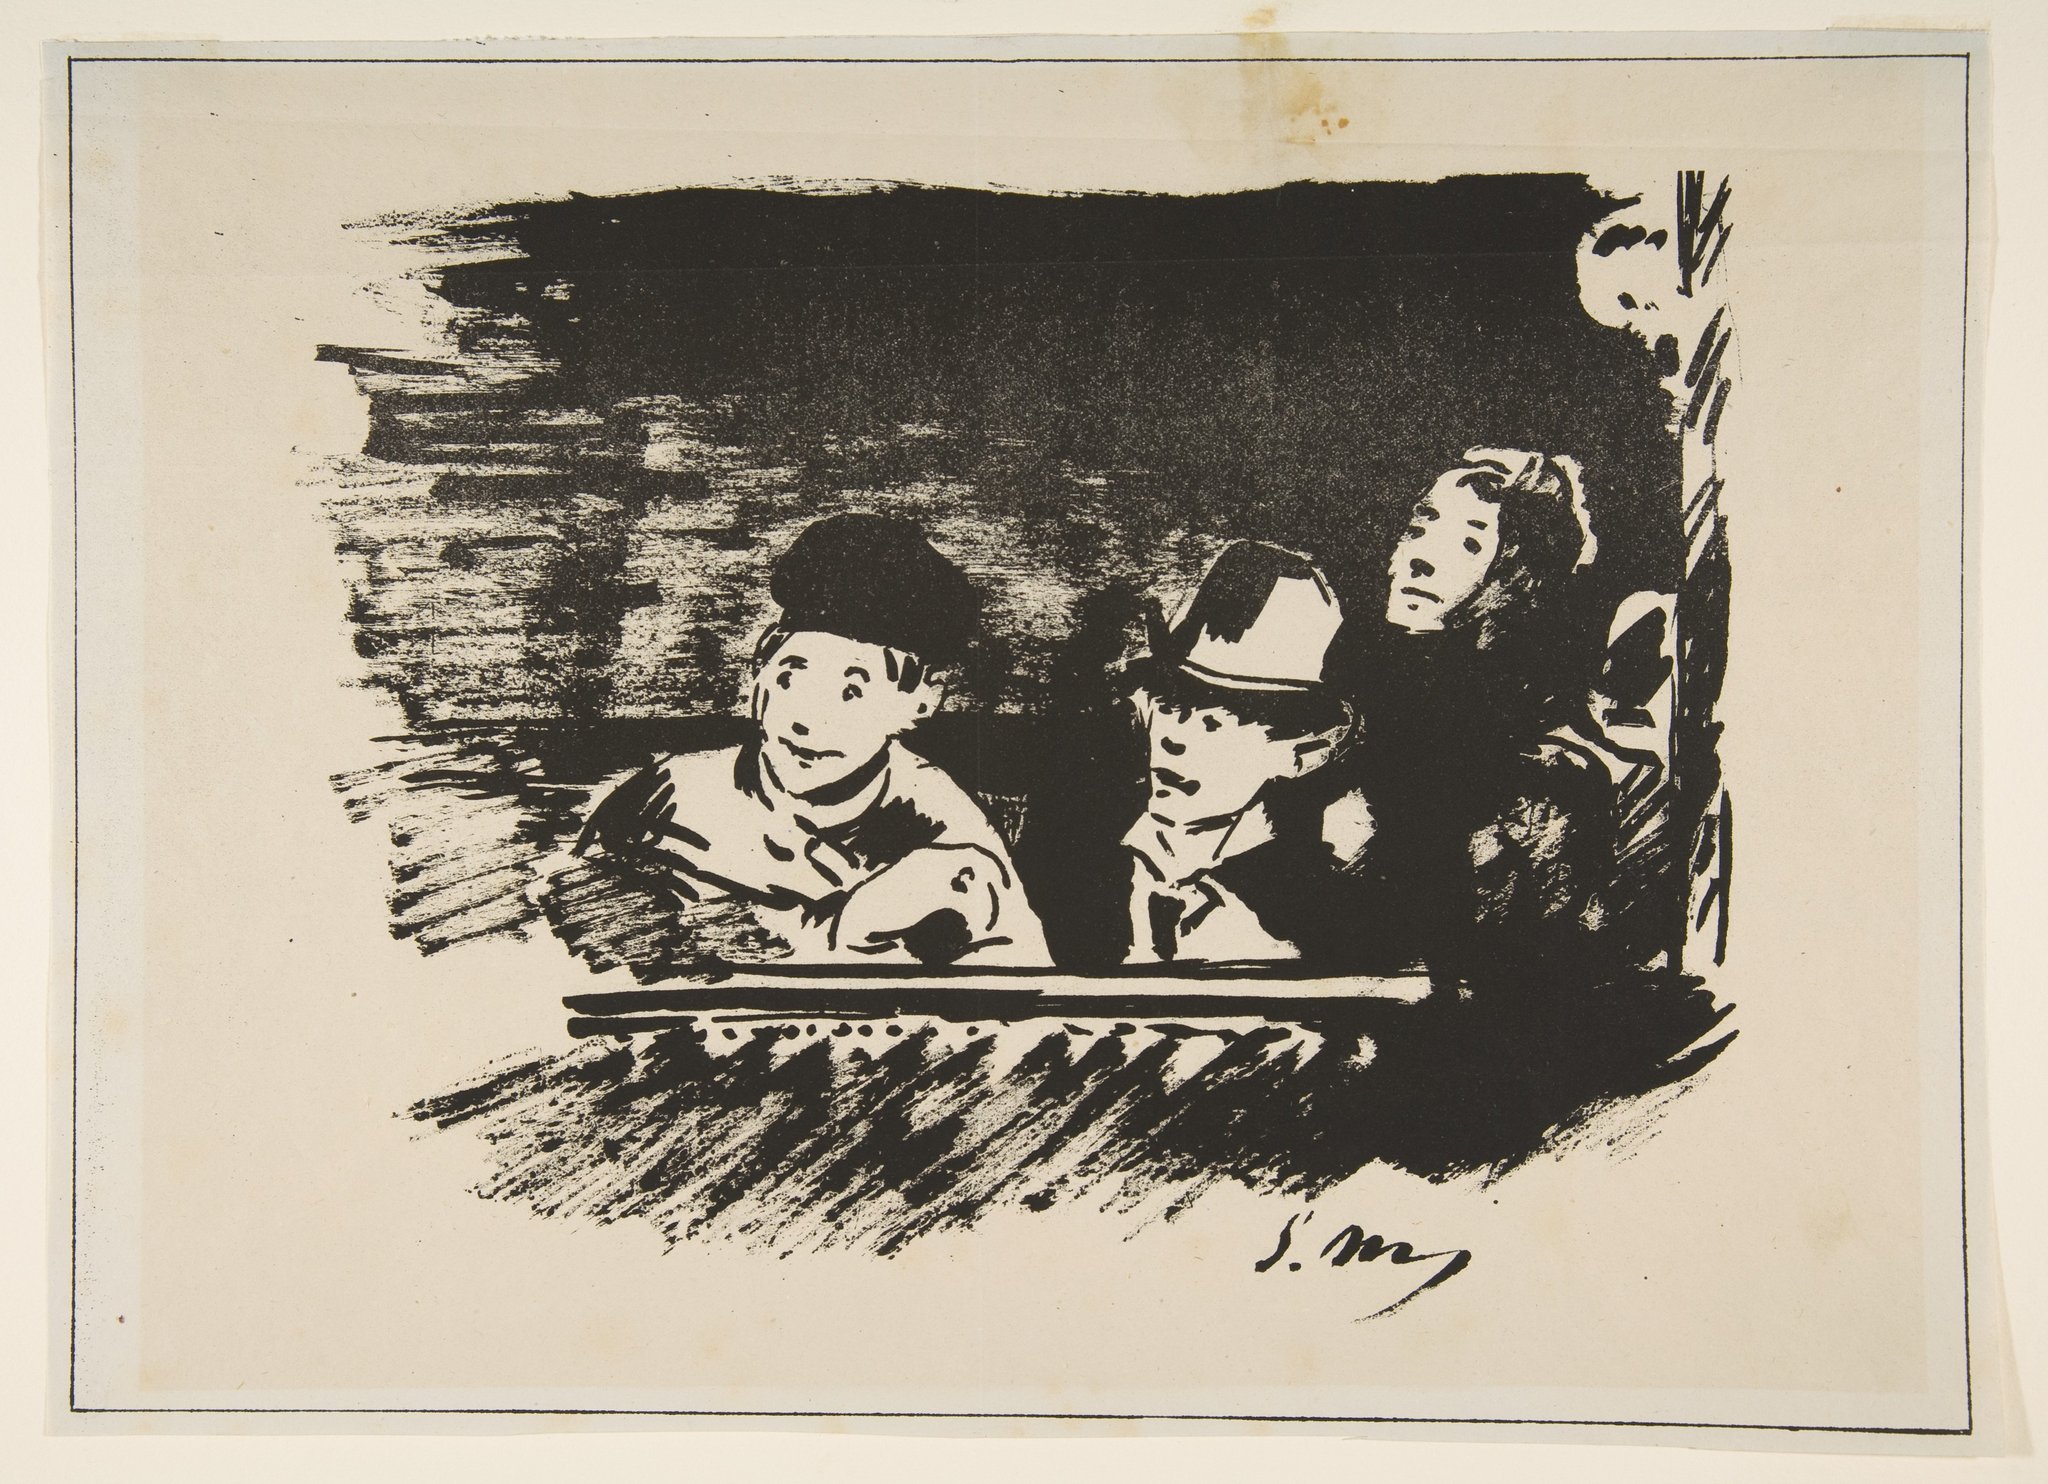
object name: print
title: In the Upper Gallery (Au Paradis)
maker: édouard manet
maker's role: artist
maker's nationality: french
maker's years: 1832-1883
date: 1877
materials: paper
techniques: lithograph, relief, transfer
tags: men